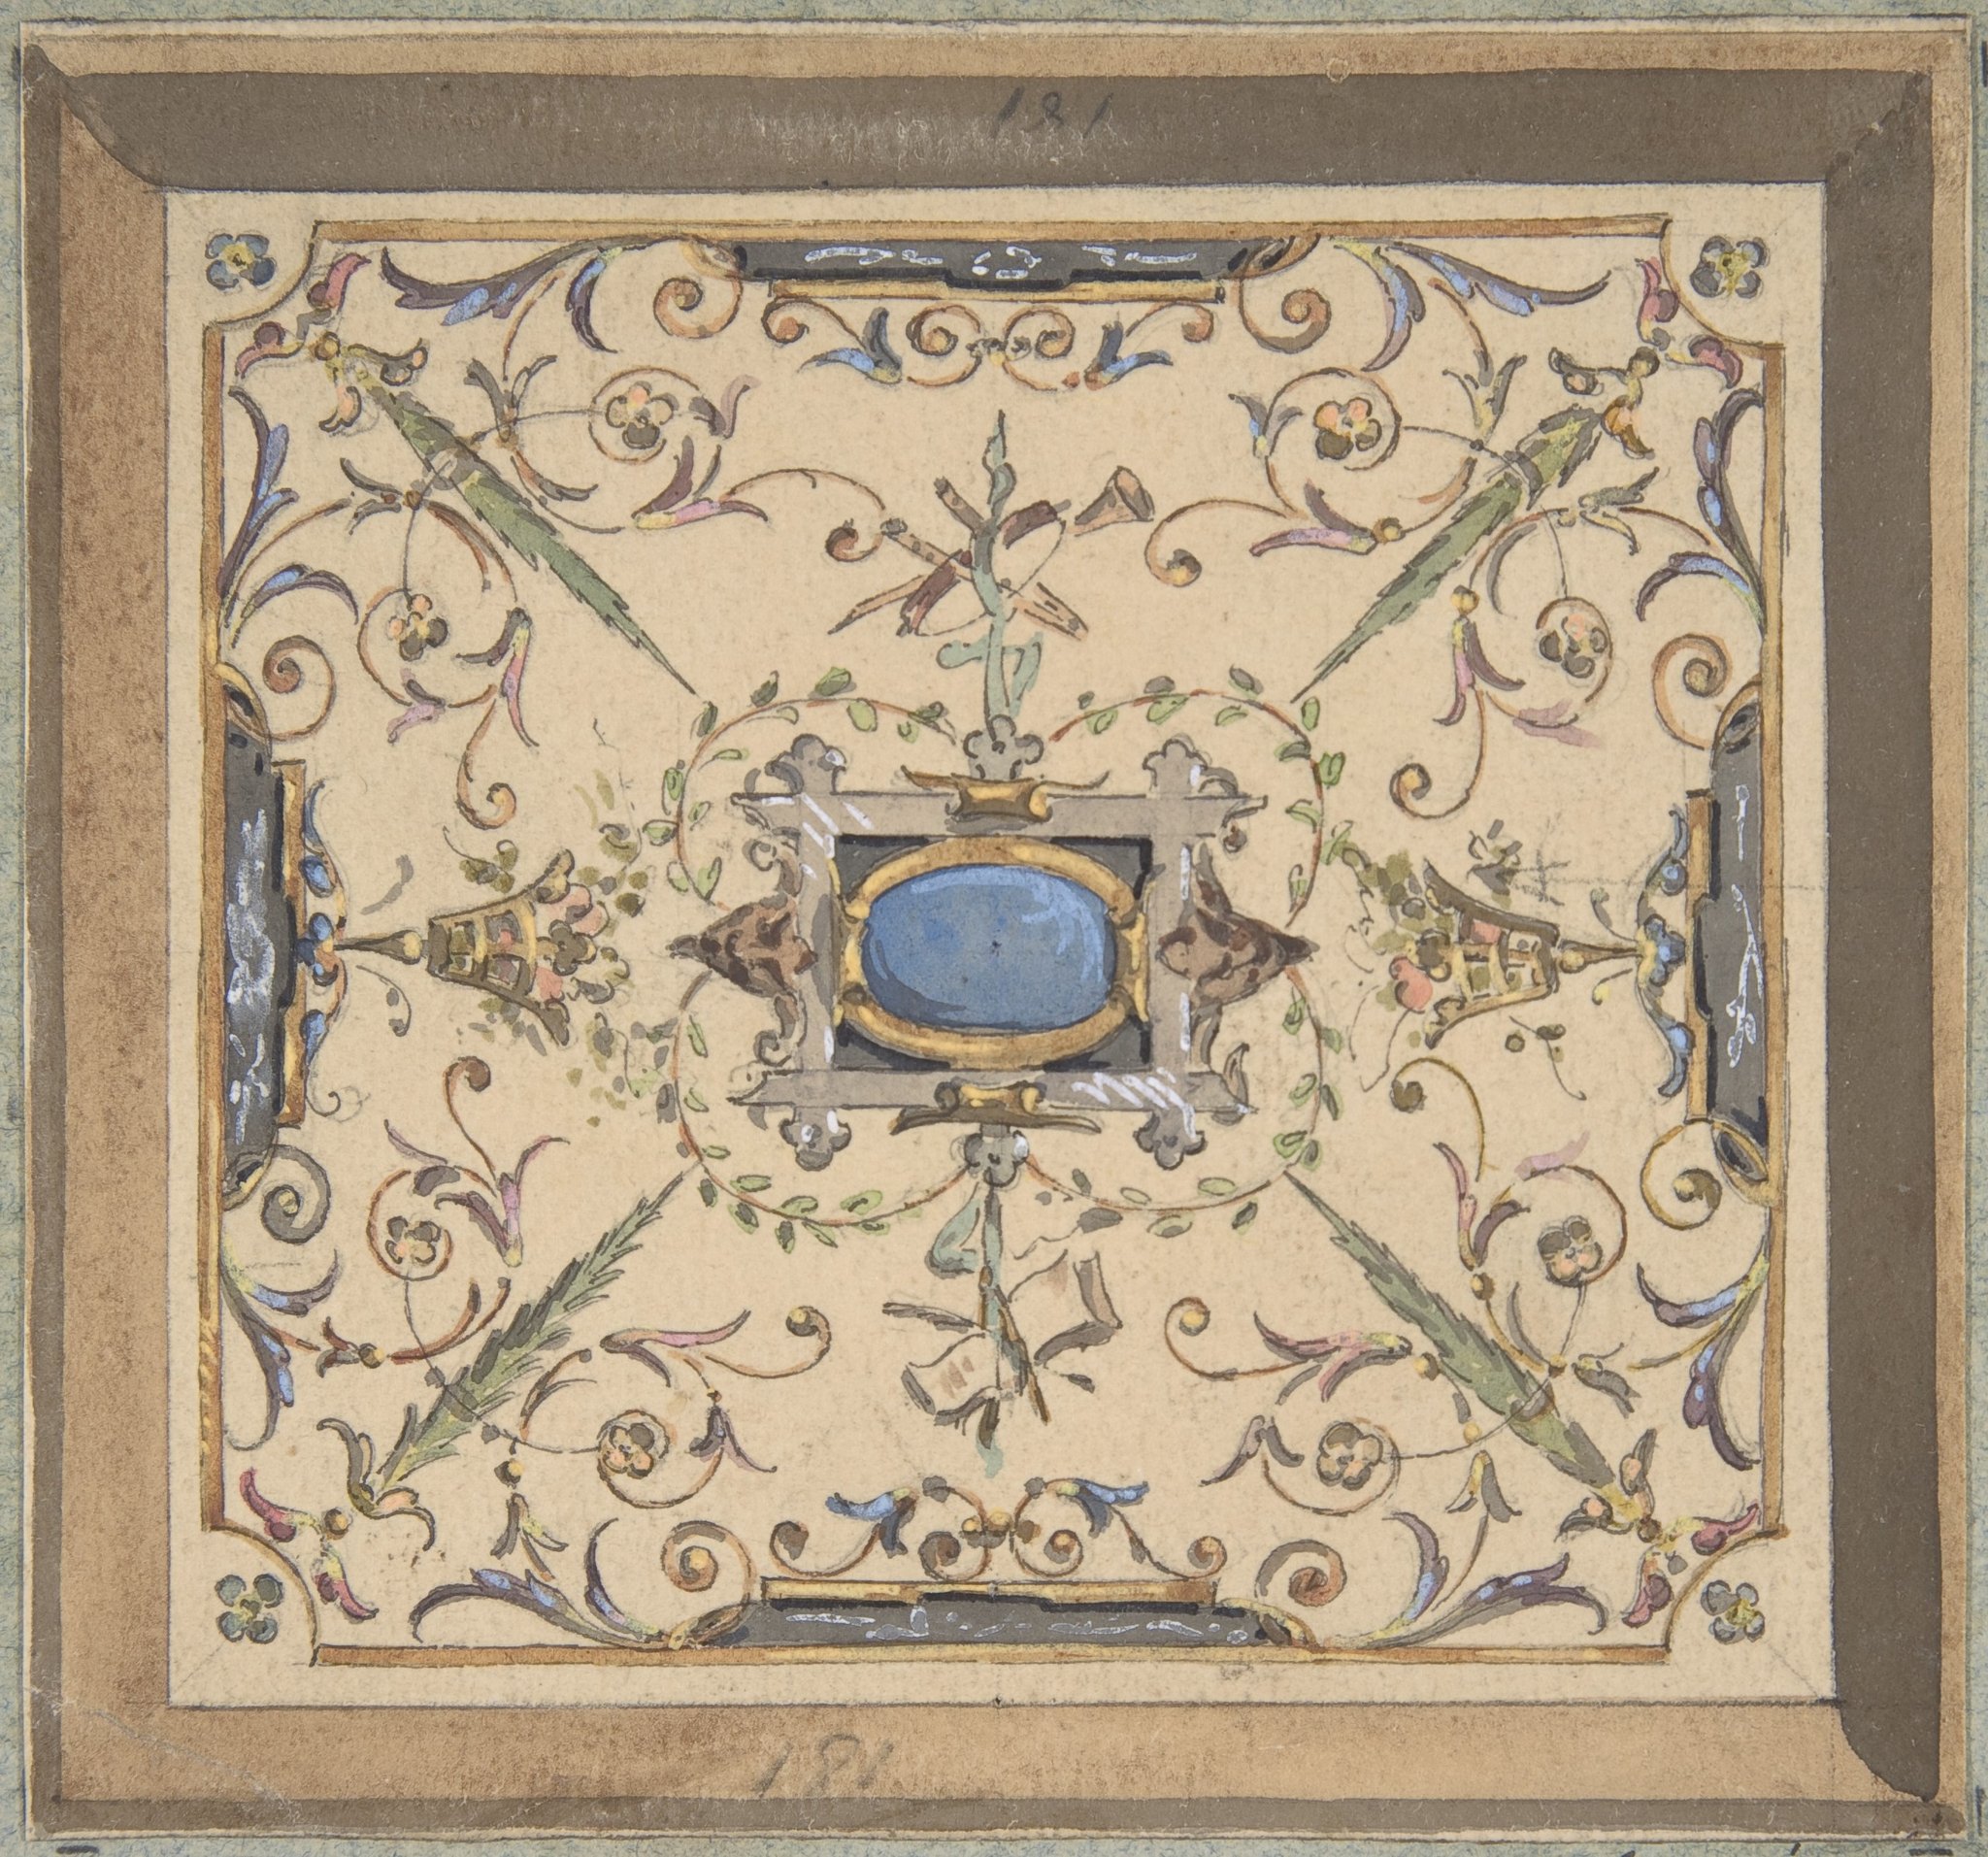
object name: drawing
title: Design for Ceiling, Château de Cangé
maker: jules-edmond-charles lachaise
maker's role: artist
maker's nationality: french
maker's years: 1897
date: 1851-1900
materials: gouache, watercolor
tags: flowers,ceilings